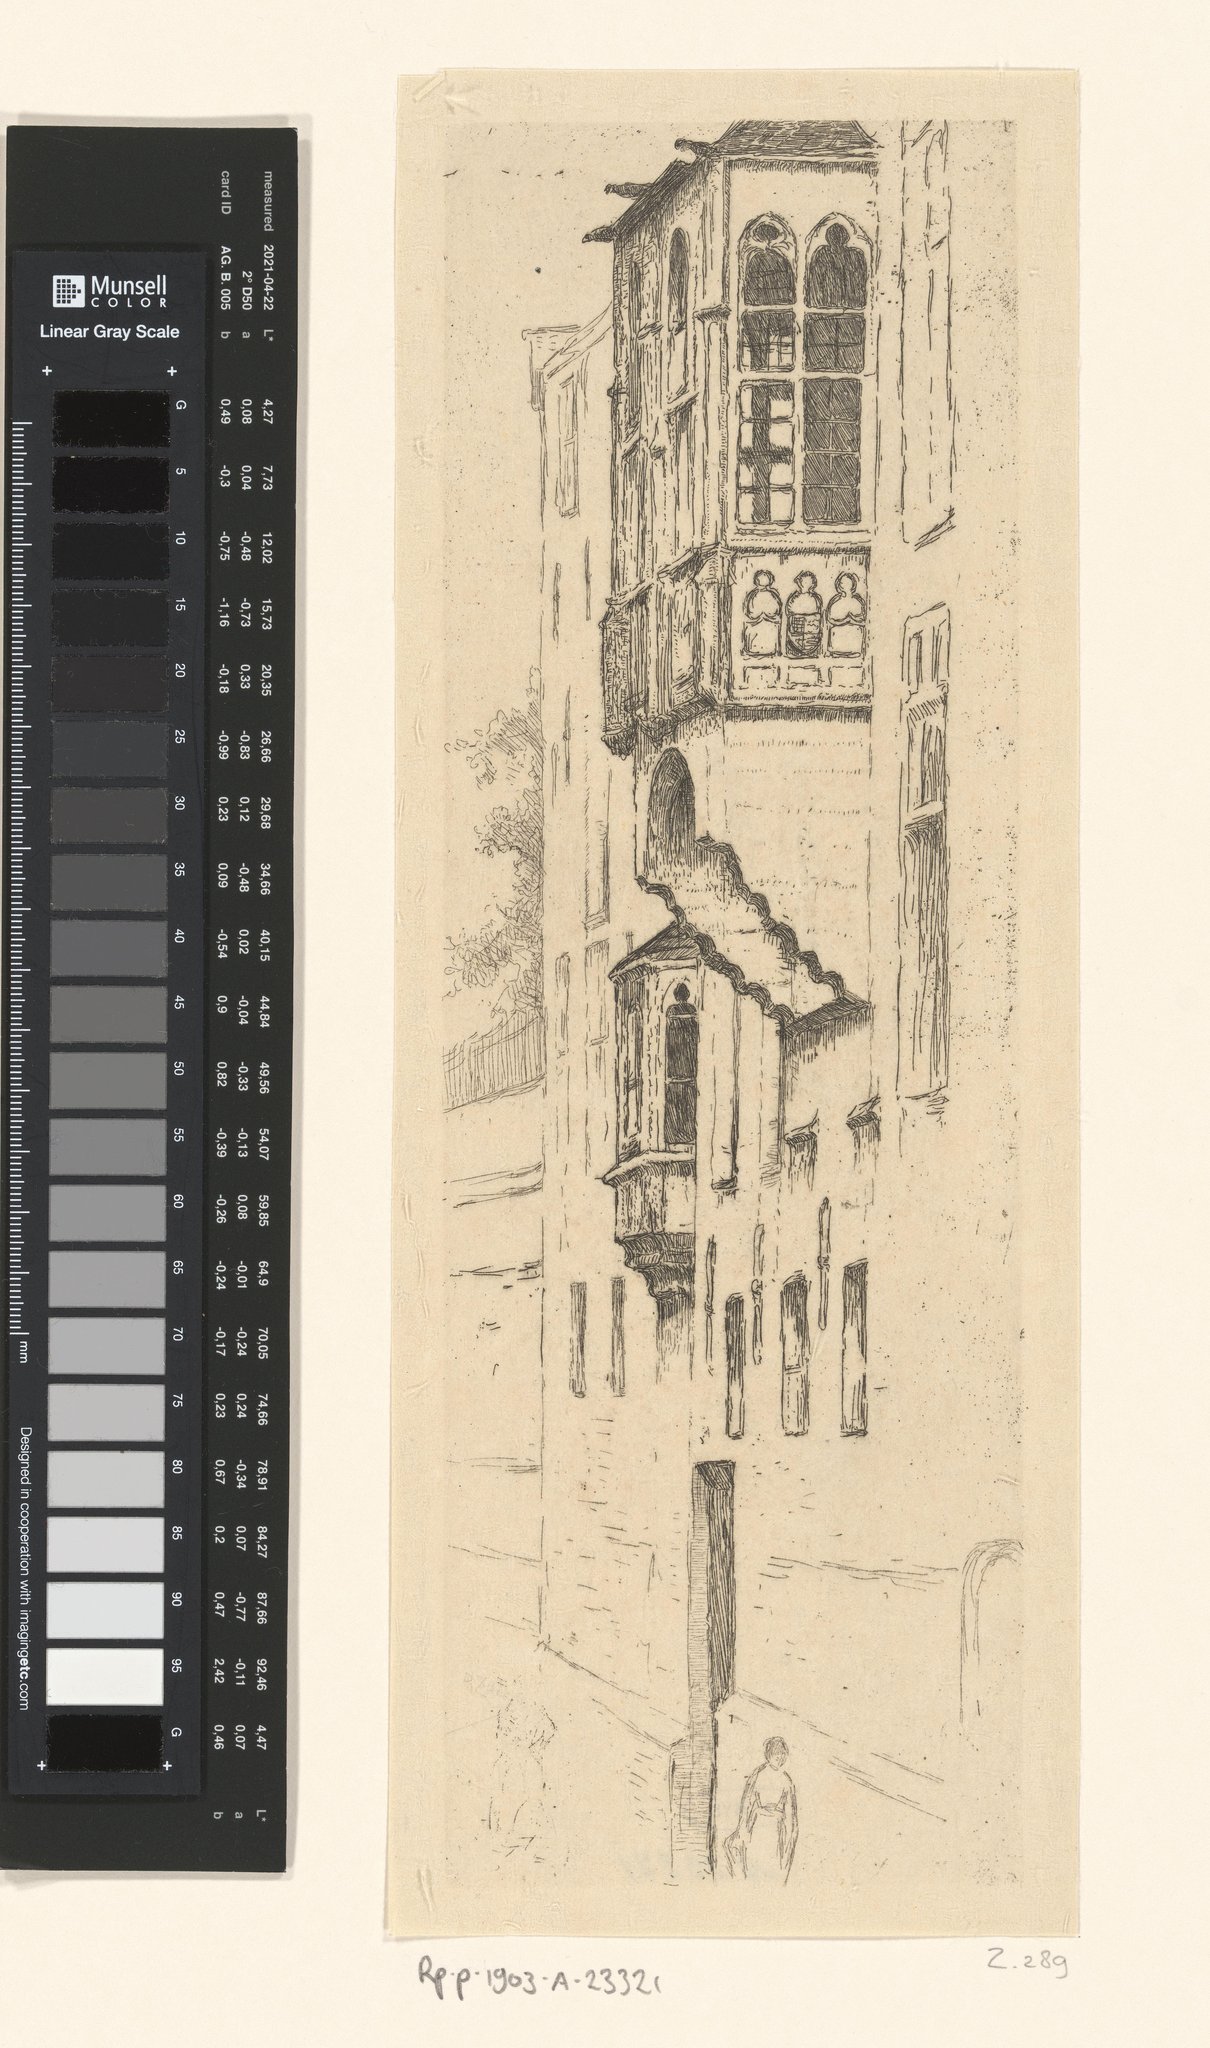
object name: print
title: Gevel van huis Ravenstein, te Brussel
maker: philip zilcken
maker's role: draughtsman, painter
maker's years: 1857-1930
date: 1890-1903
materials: paper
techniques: etching, intaglio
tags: urban housing, bay-window, oriel, brussels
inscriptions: collector's mark: Lugt 2228